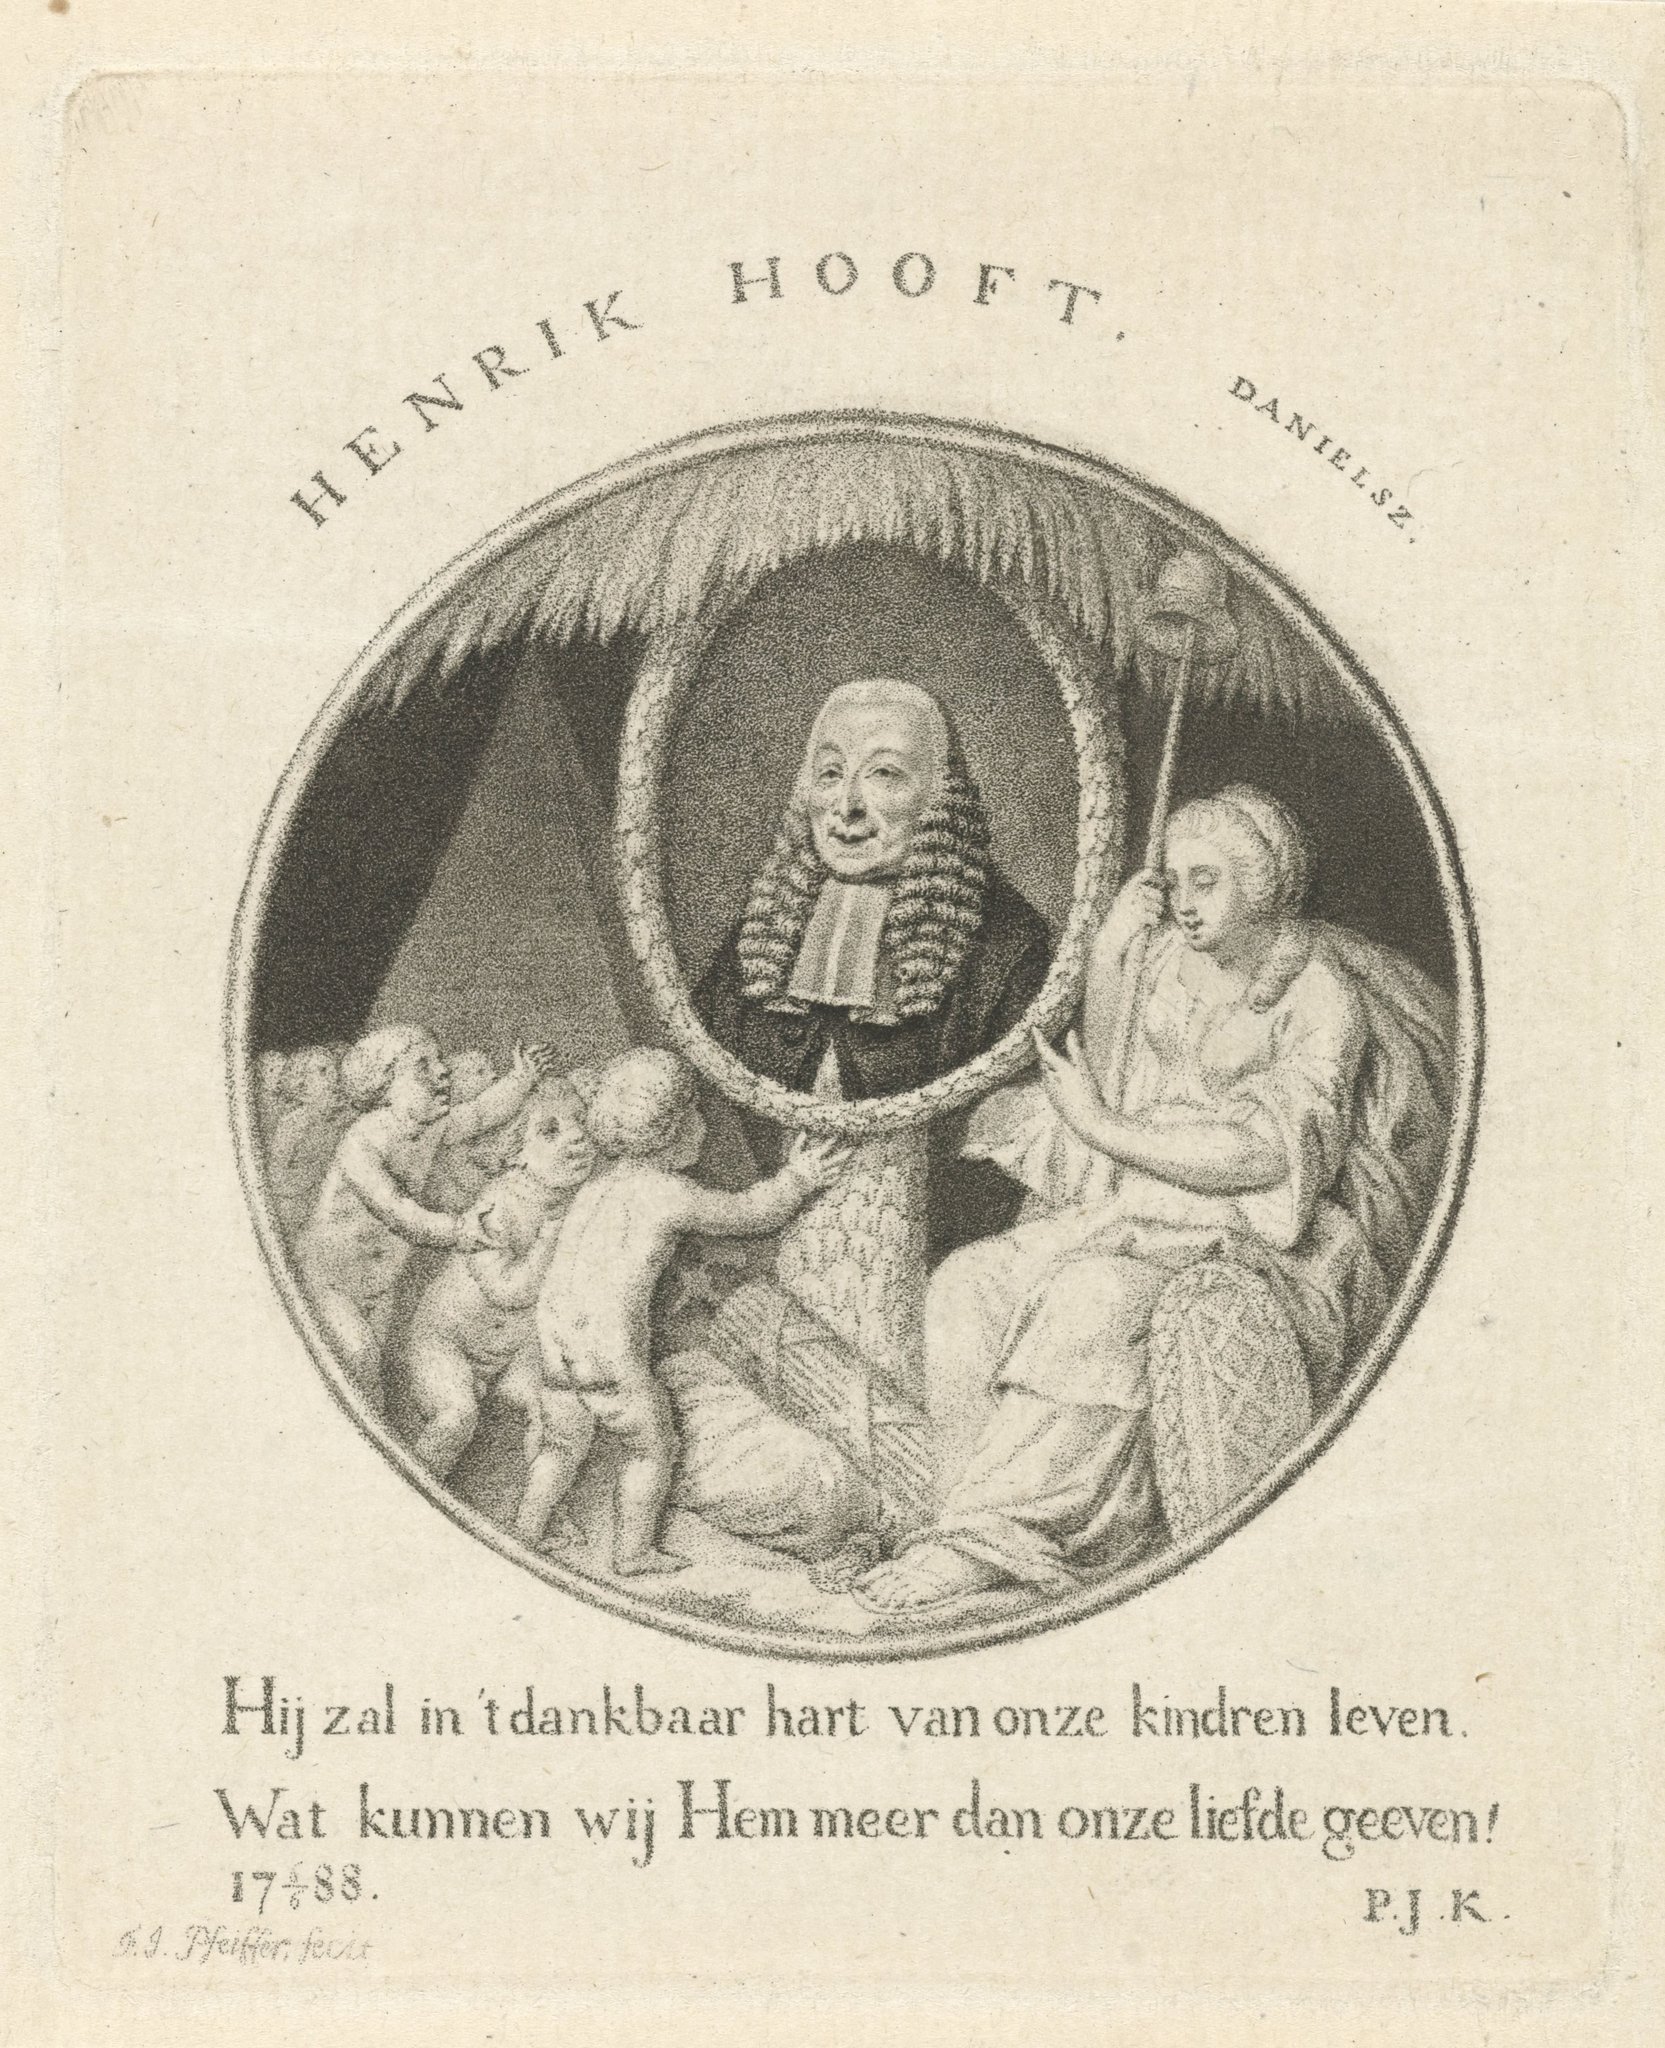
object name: print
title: Memorieprent voor Hendrik Danielsz. Hooft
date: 1794-1796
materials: paper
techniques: aquatint, etching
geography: amsterdam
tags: amsterdam, hendrik danielsz. hooft, mayor, burgomaster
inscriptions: collector's mark: Lugt 2233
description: De Amsterdamse stedenmaagd, met de vrijheidshoed op een lans in de hand, wijst naar het portret van Hendrik Hooft Danielsz., burgemeester van Amsterdam.